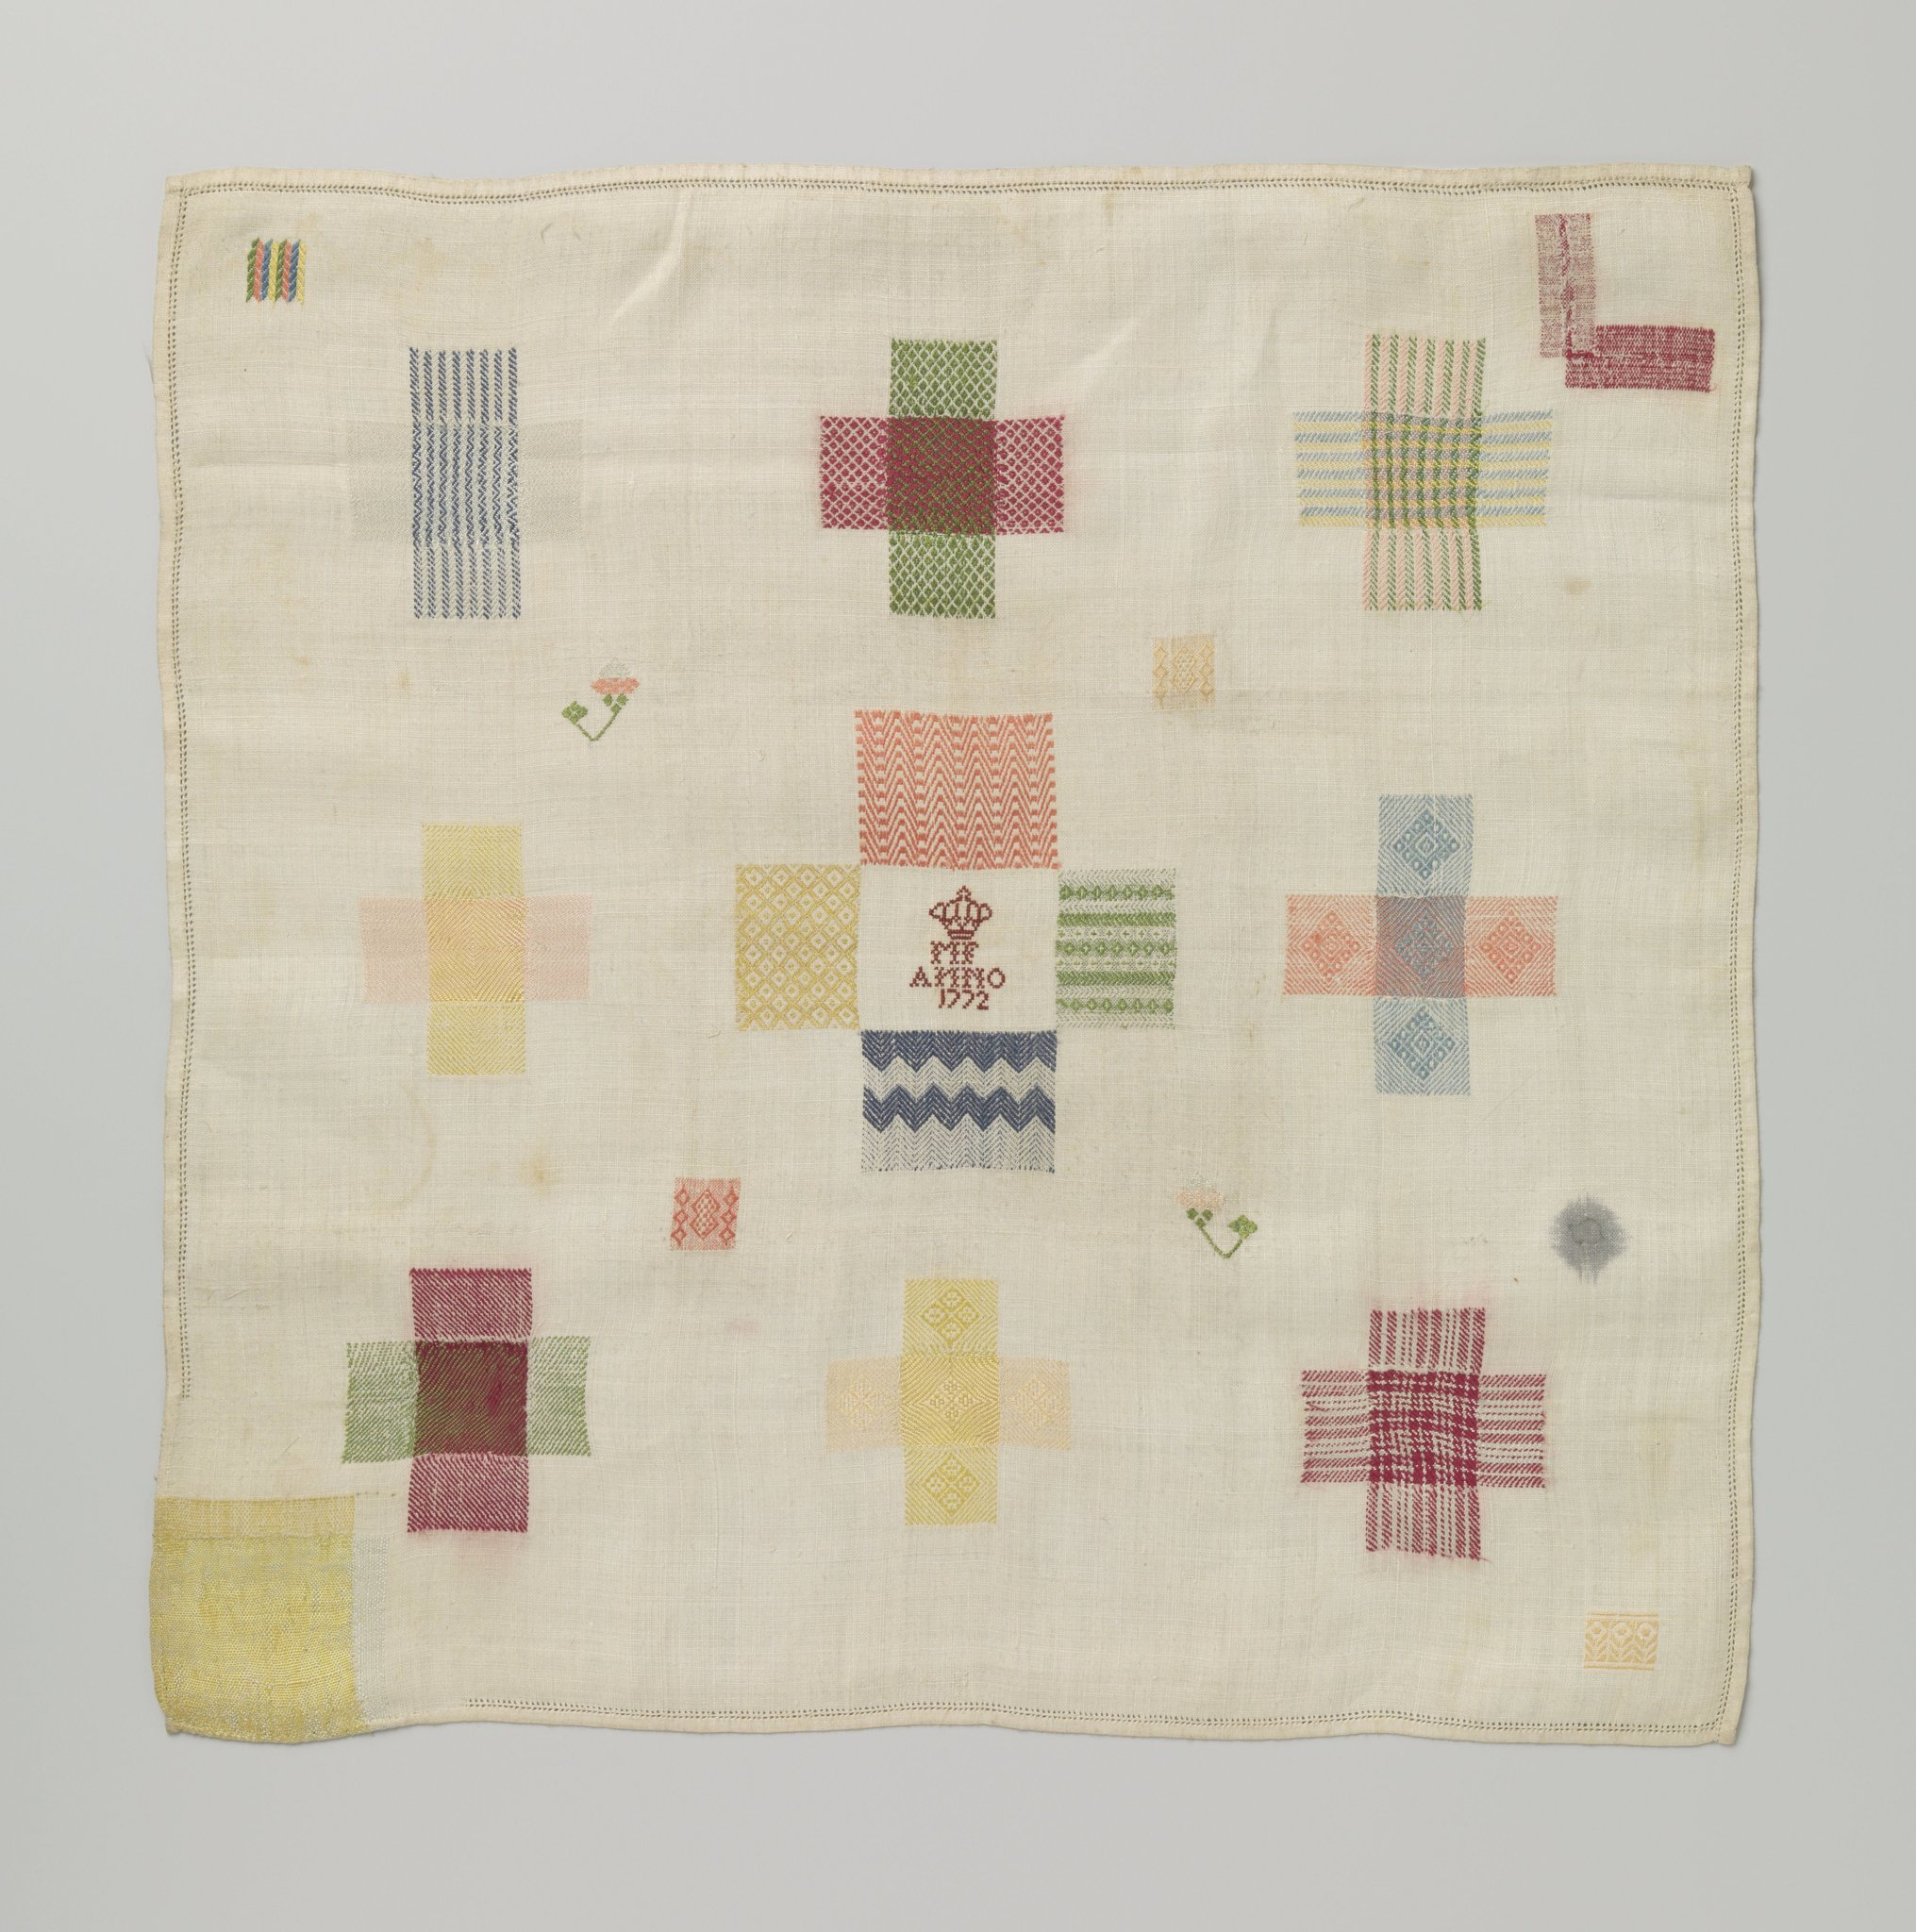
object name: stoplap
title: Stoplap van veelkleurige zijde op linnen.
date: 1772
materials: linen, silk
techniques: embroidered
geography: amsterdam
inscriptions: date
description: Stoplap met veelkleurig borduurwerk. Het borduurwerk bestaat uit de initialen MF, ANNO 1772 onder een kroon, waar omheen vier doorstoppatronen.